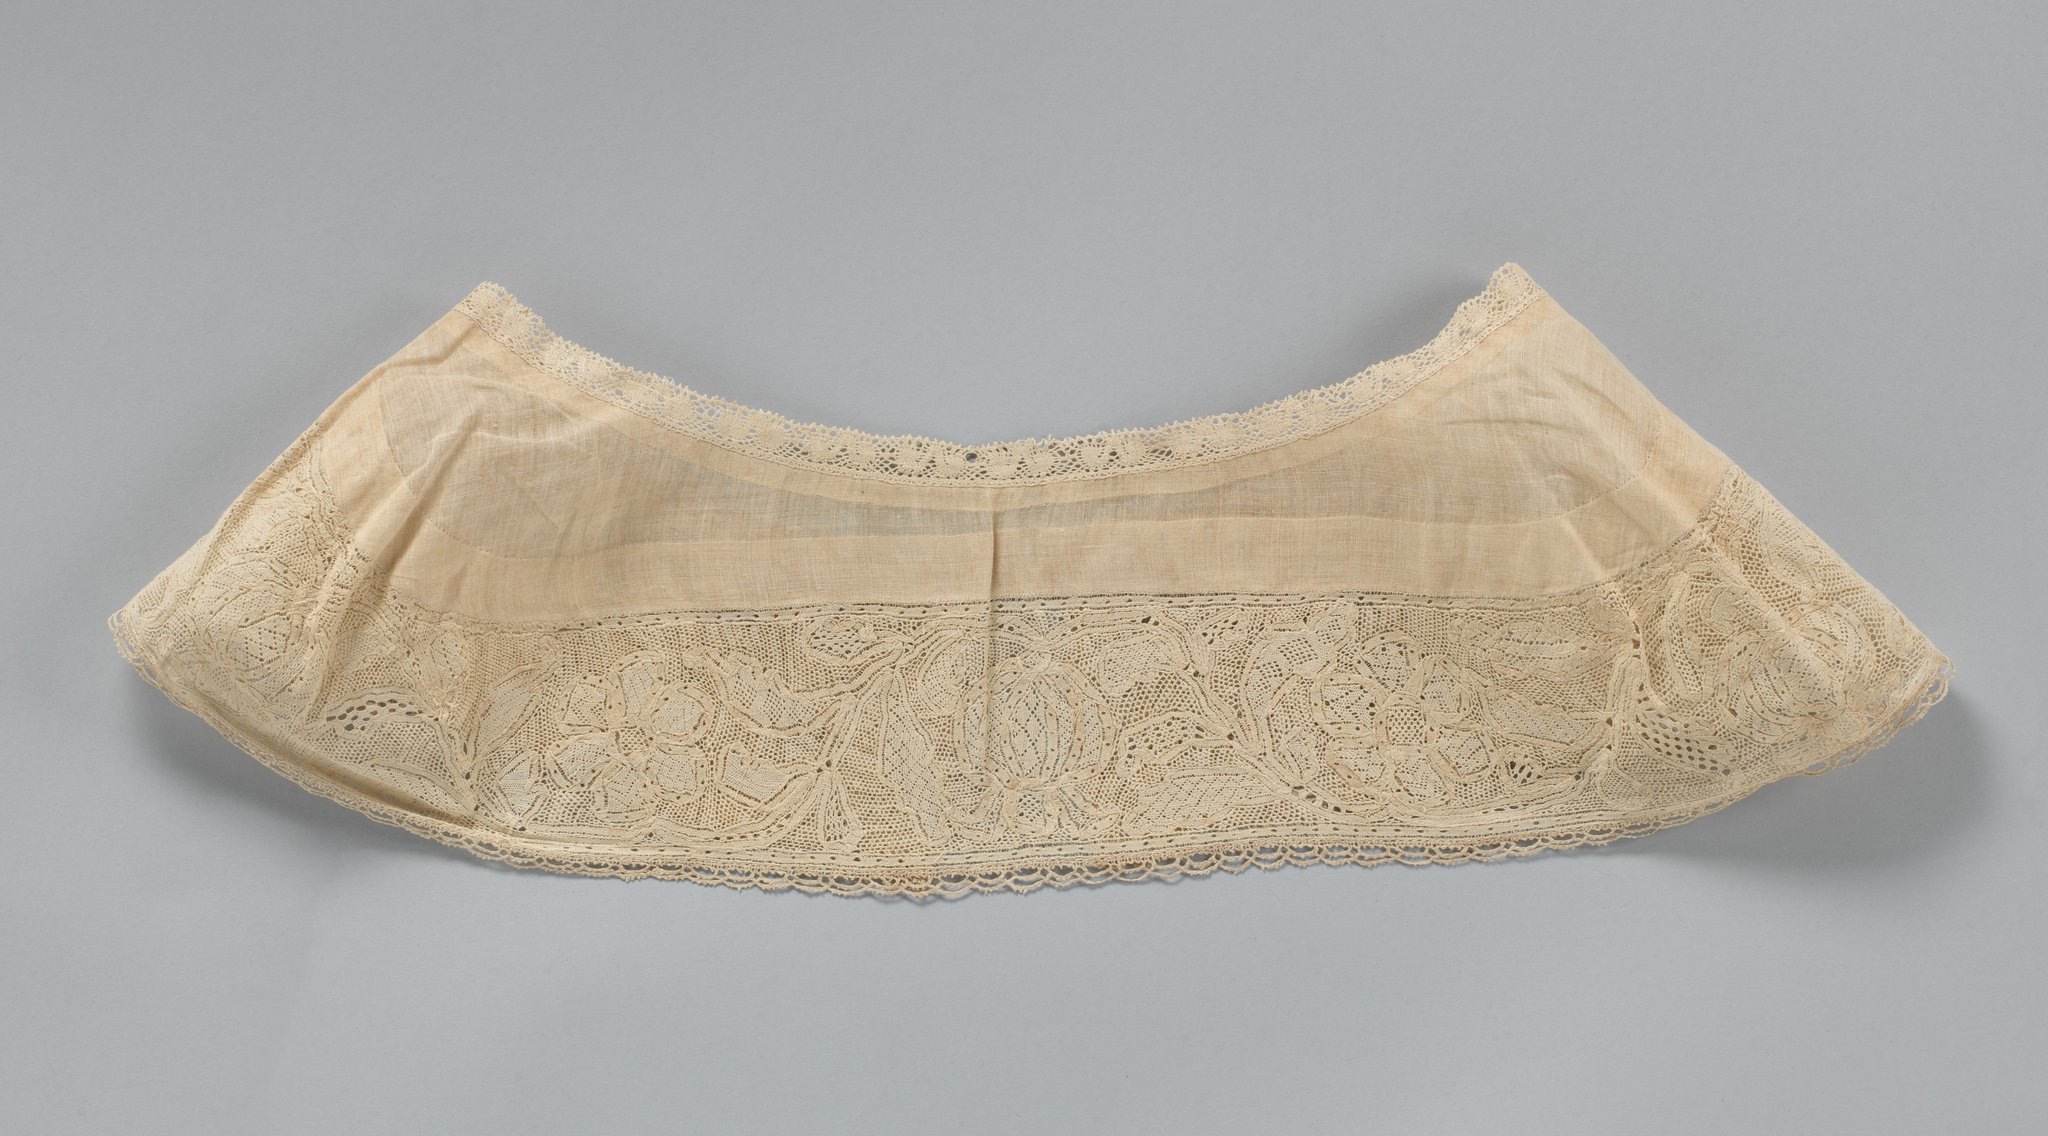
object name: collar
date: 1660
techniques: lace